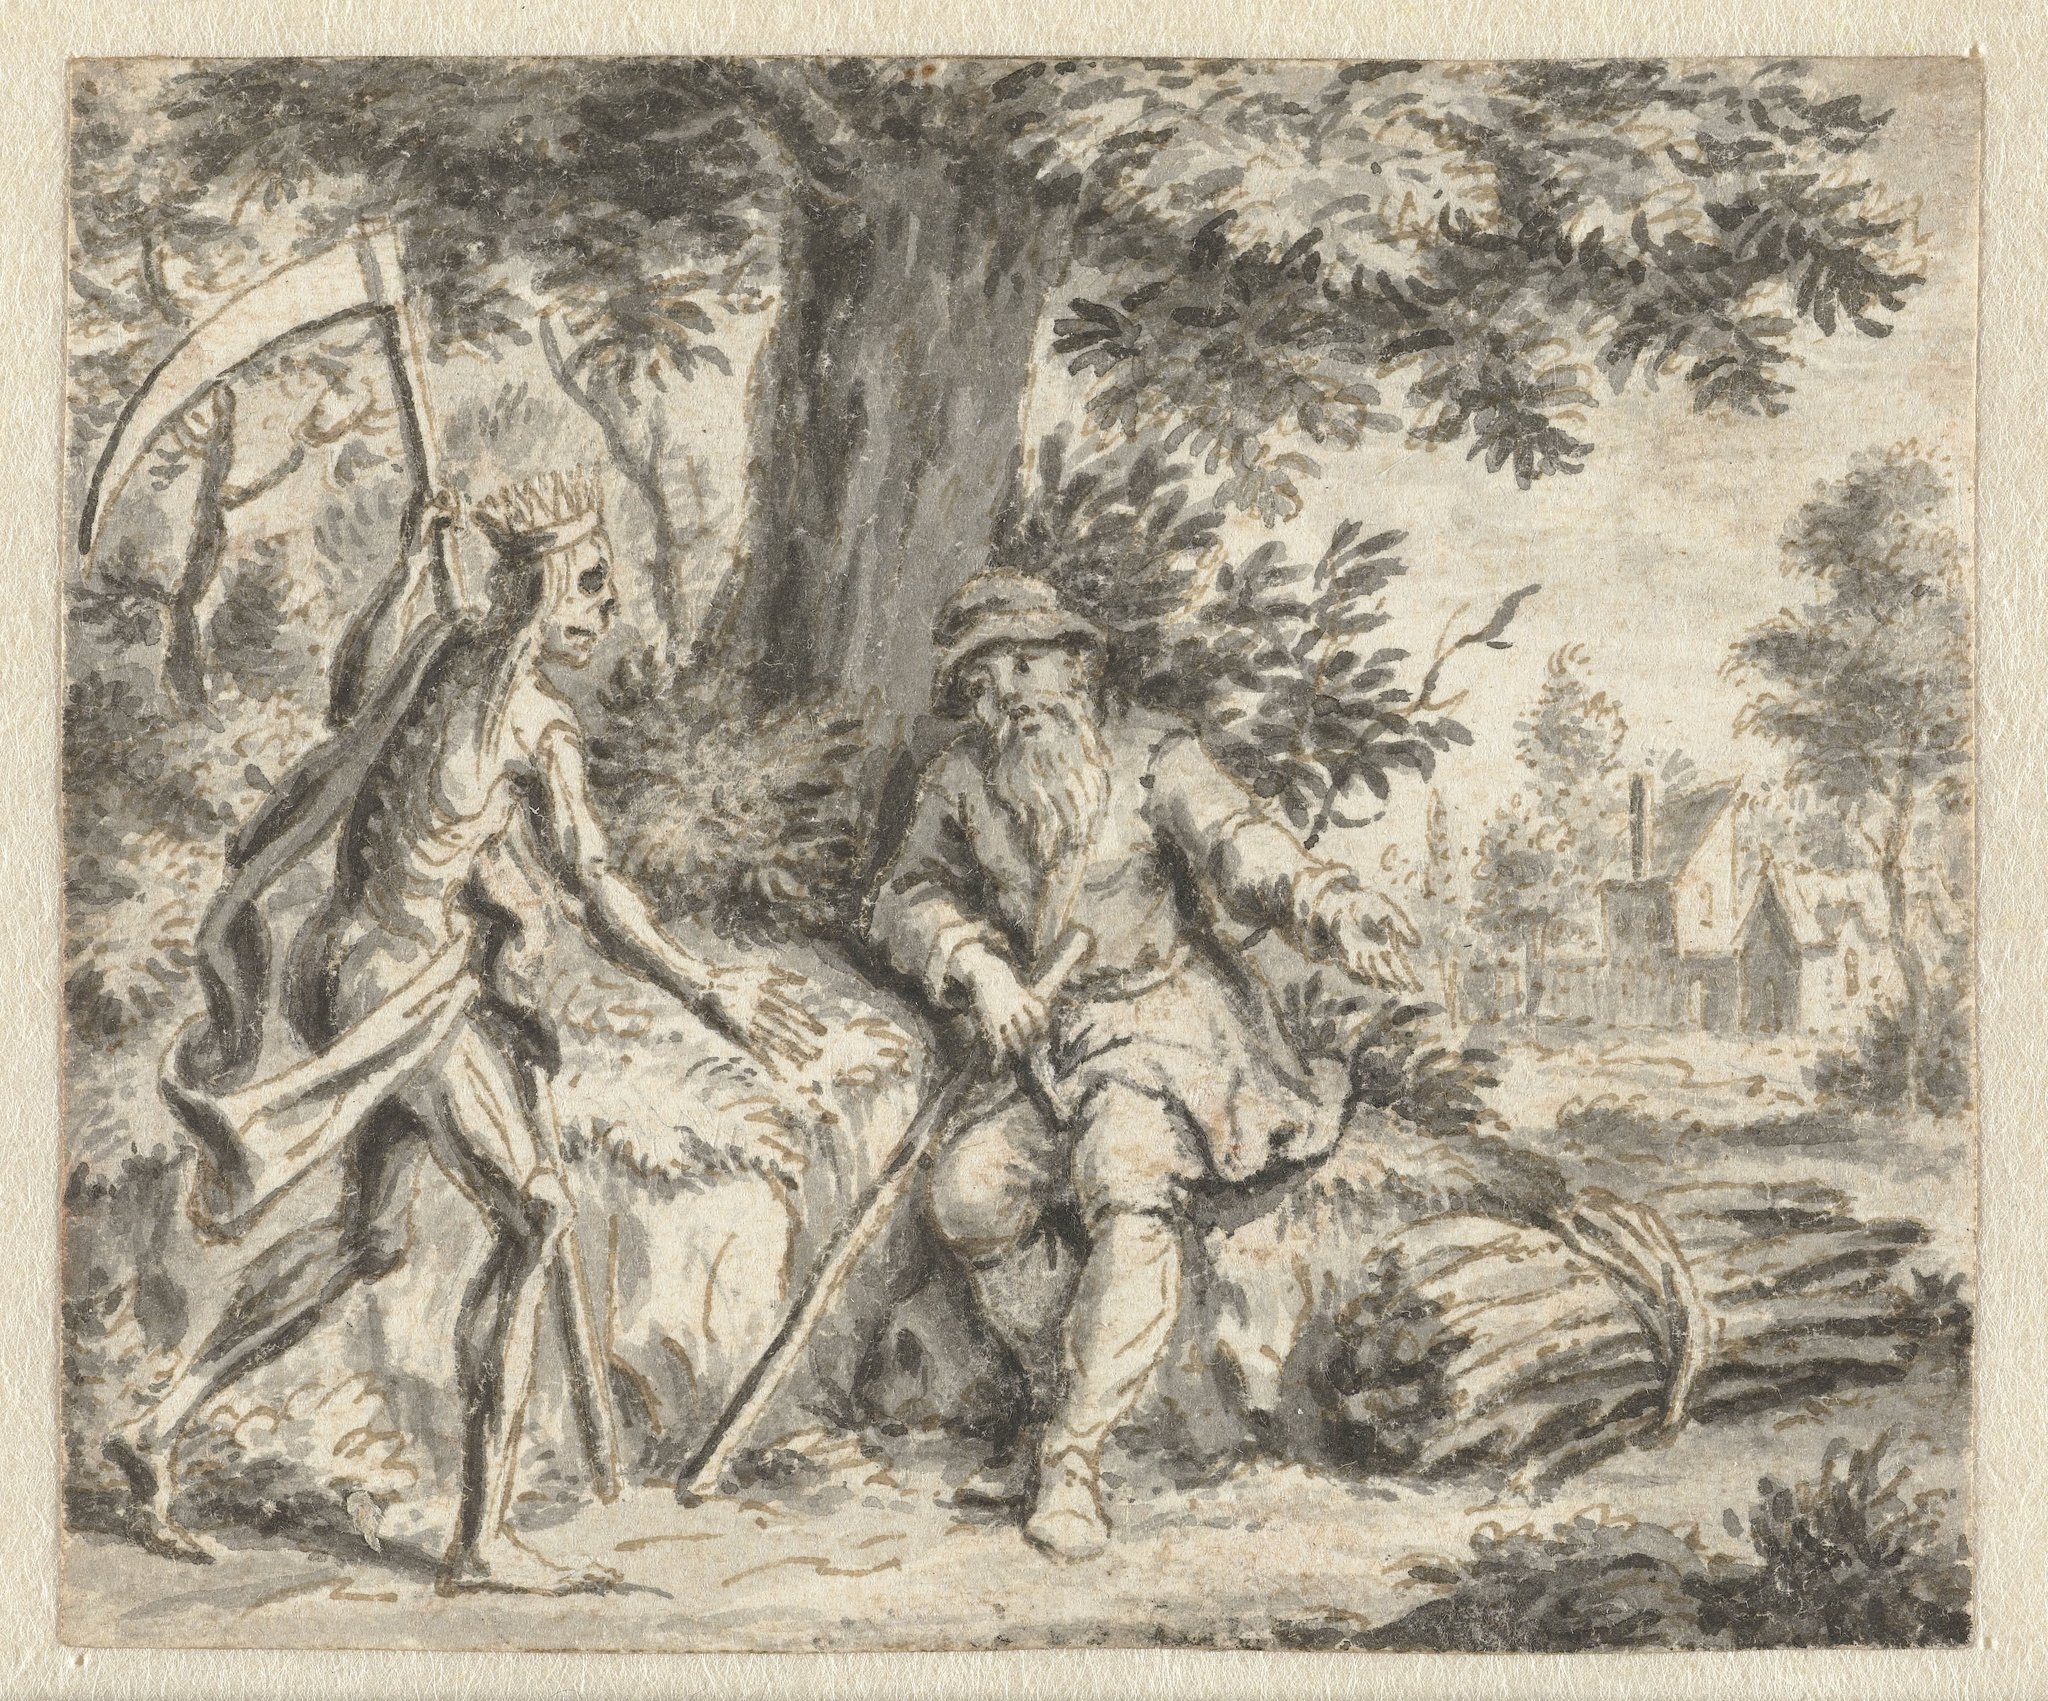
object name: design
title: Houthakker en de dood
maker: Anonymous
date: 1668-1740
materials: chalk, ink, paper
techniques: brush, pen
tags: woodgathering, woodgatherer, death as (rotting) corpse, fables of lafontaine (with title) : use 85(...)